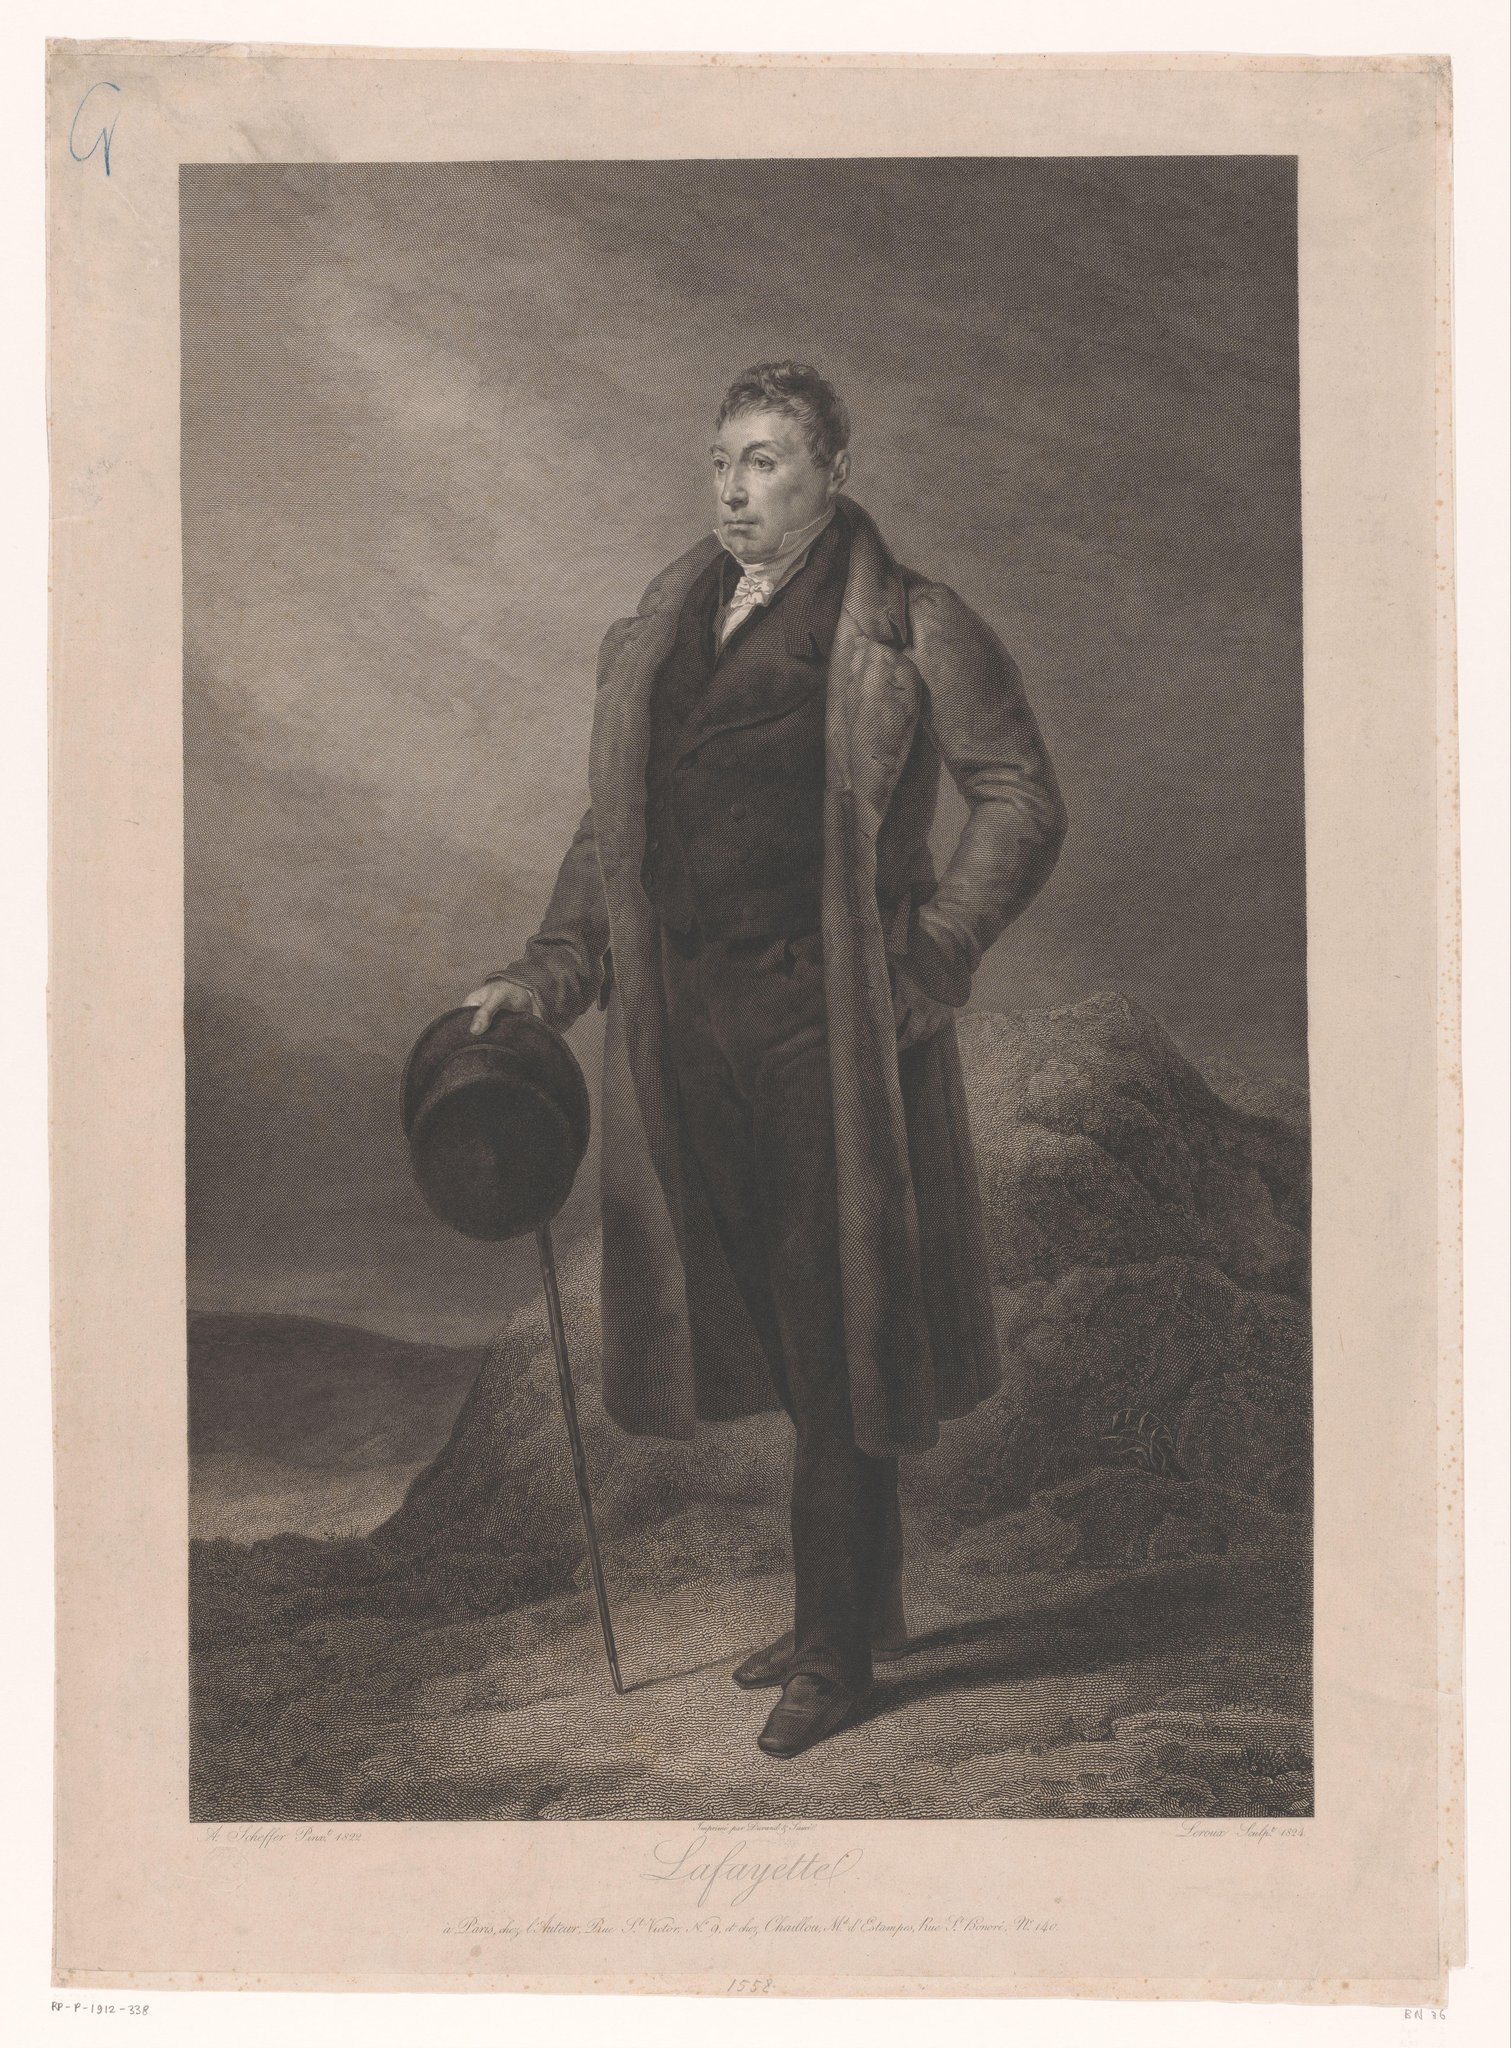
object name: print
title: Portret van Gilbert du Motier, markies de la Fayette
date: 1824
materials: paper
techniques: engraving, etching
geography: paris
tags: paris, politician, walking-stick, staff, historical persons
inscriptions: check stamp, collector's mark: Lugt 2228, inscription: ‘G’